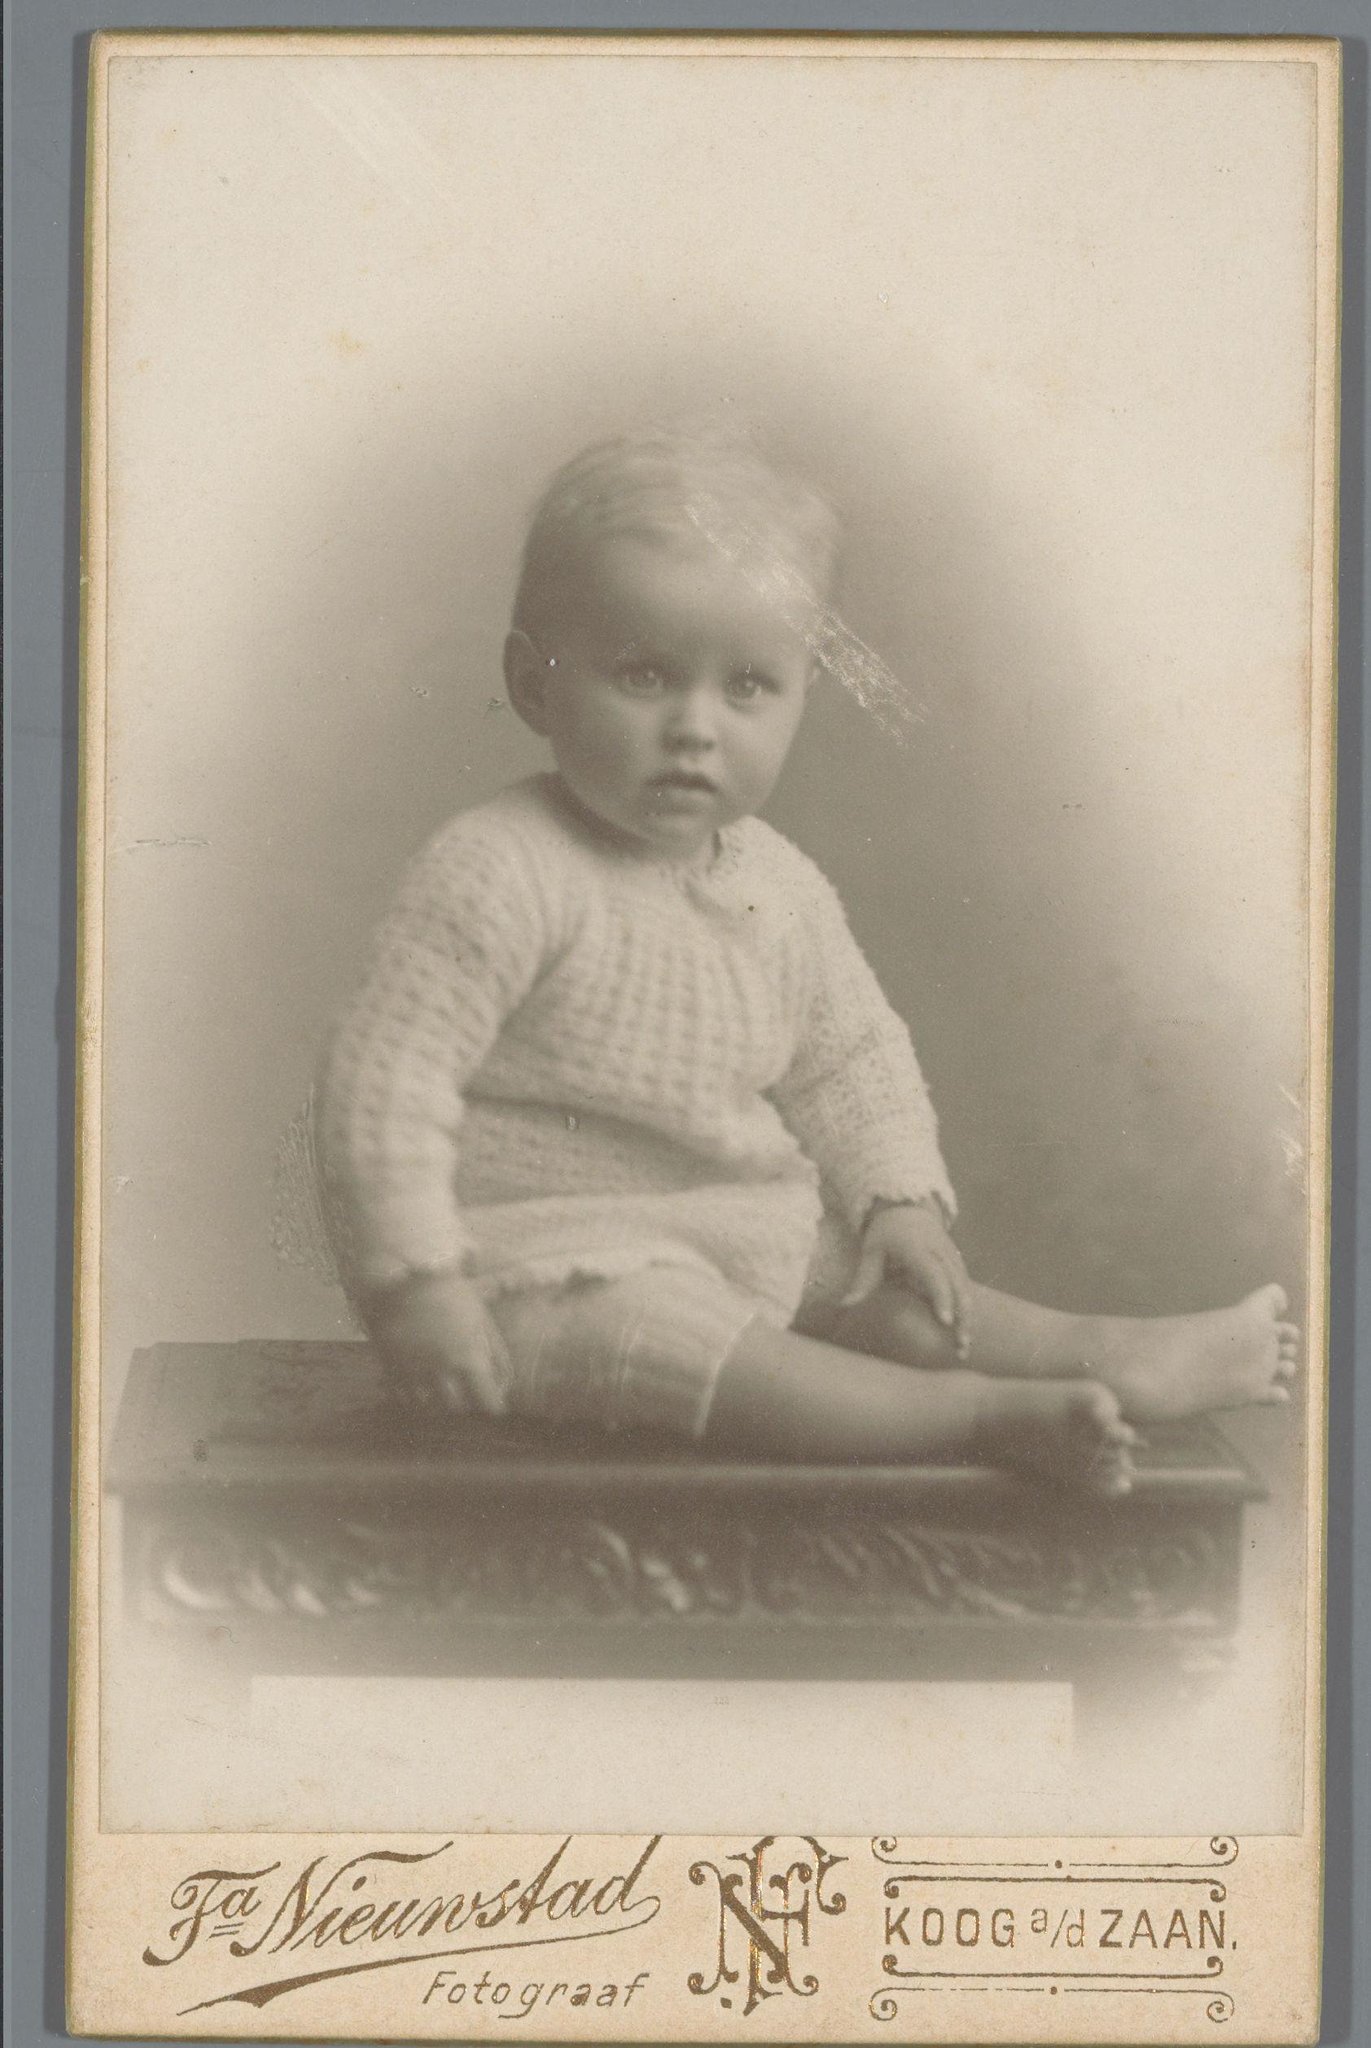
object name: carte de visite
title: Portret van een onbekende baby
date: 1900-1914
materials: paper, cardboard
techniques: gelatin silver print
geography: koog aan de zaan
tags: anonymous historical person portrayed, infant, baby